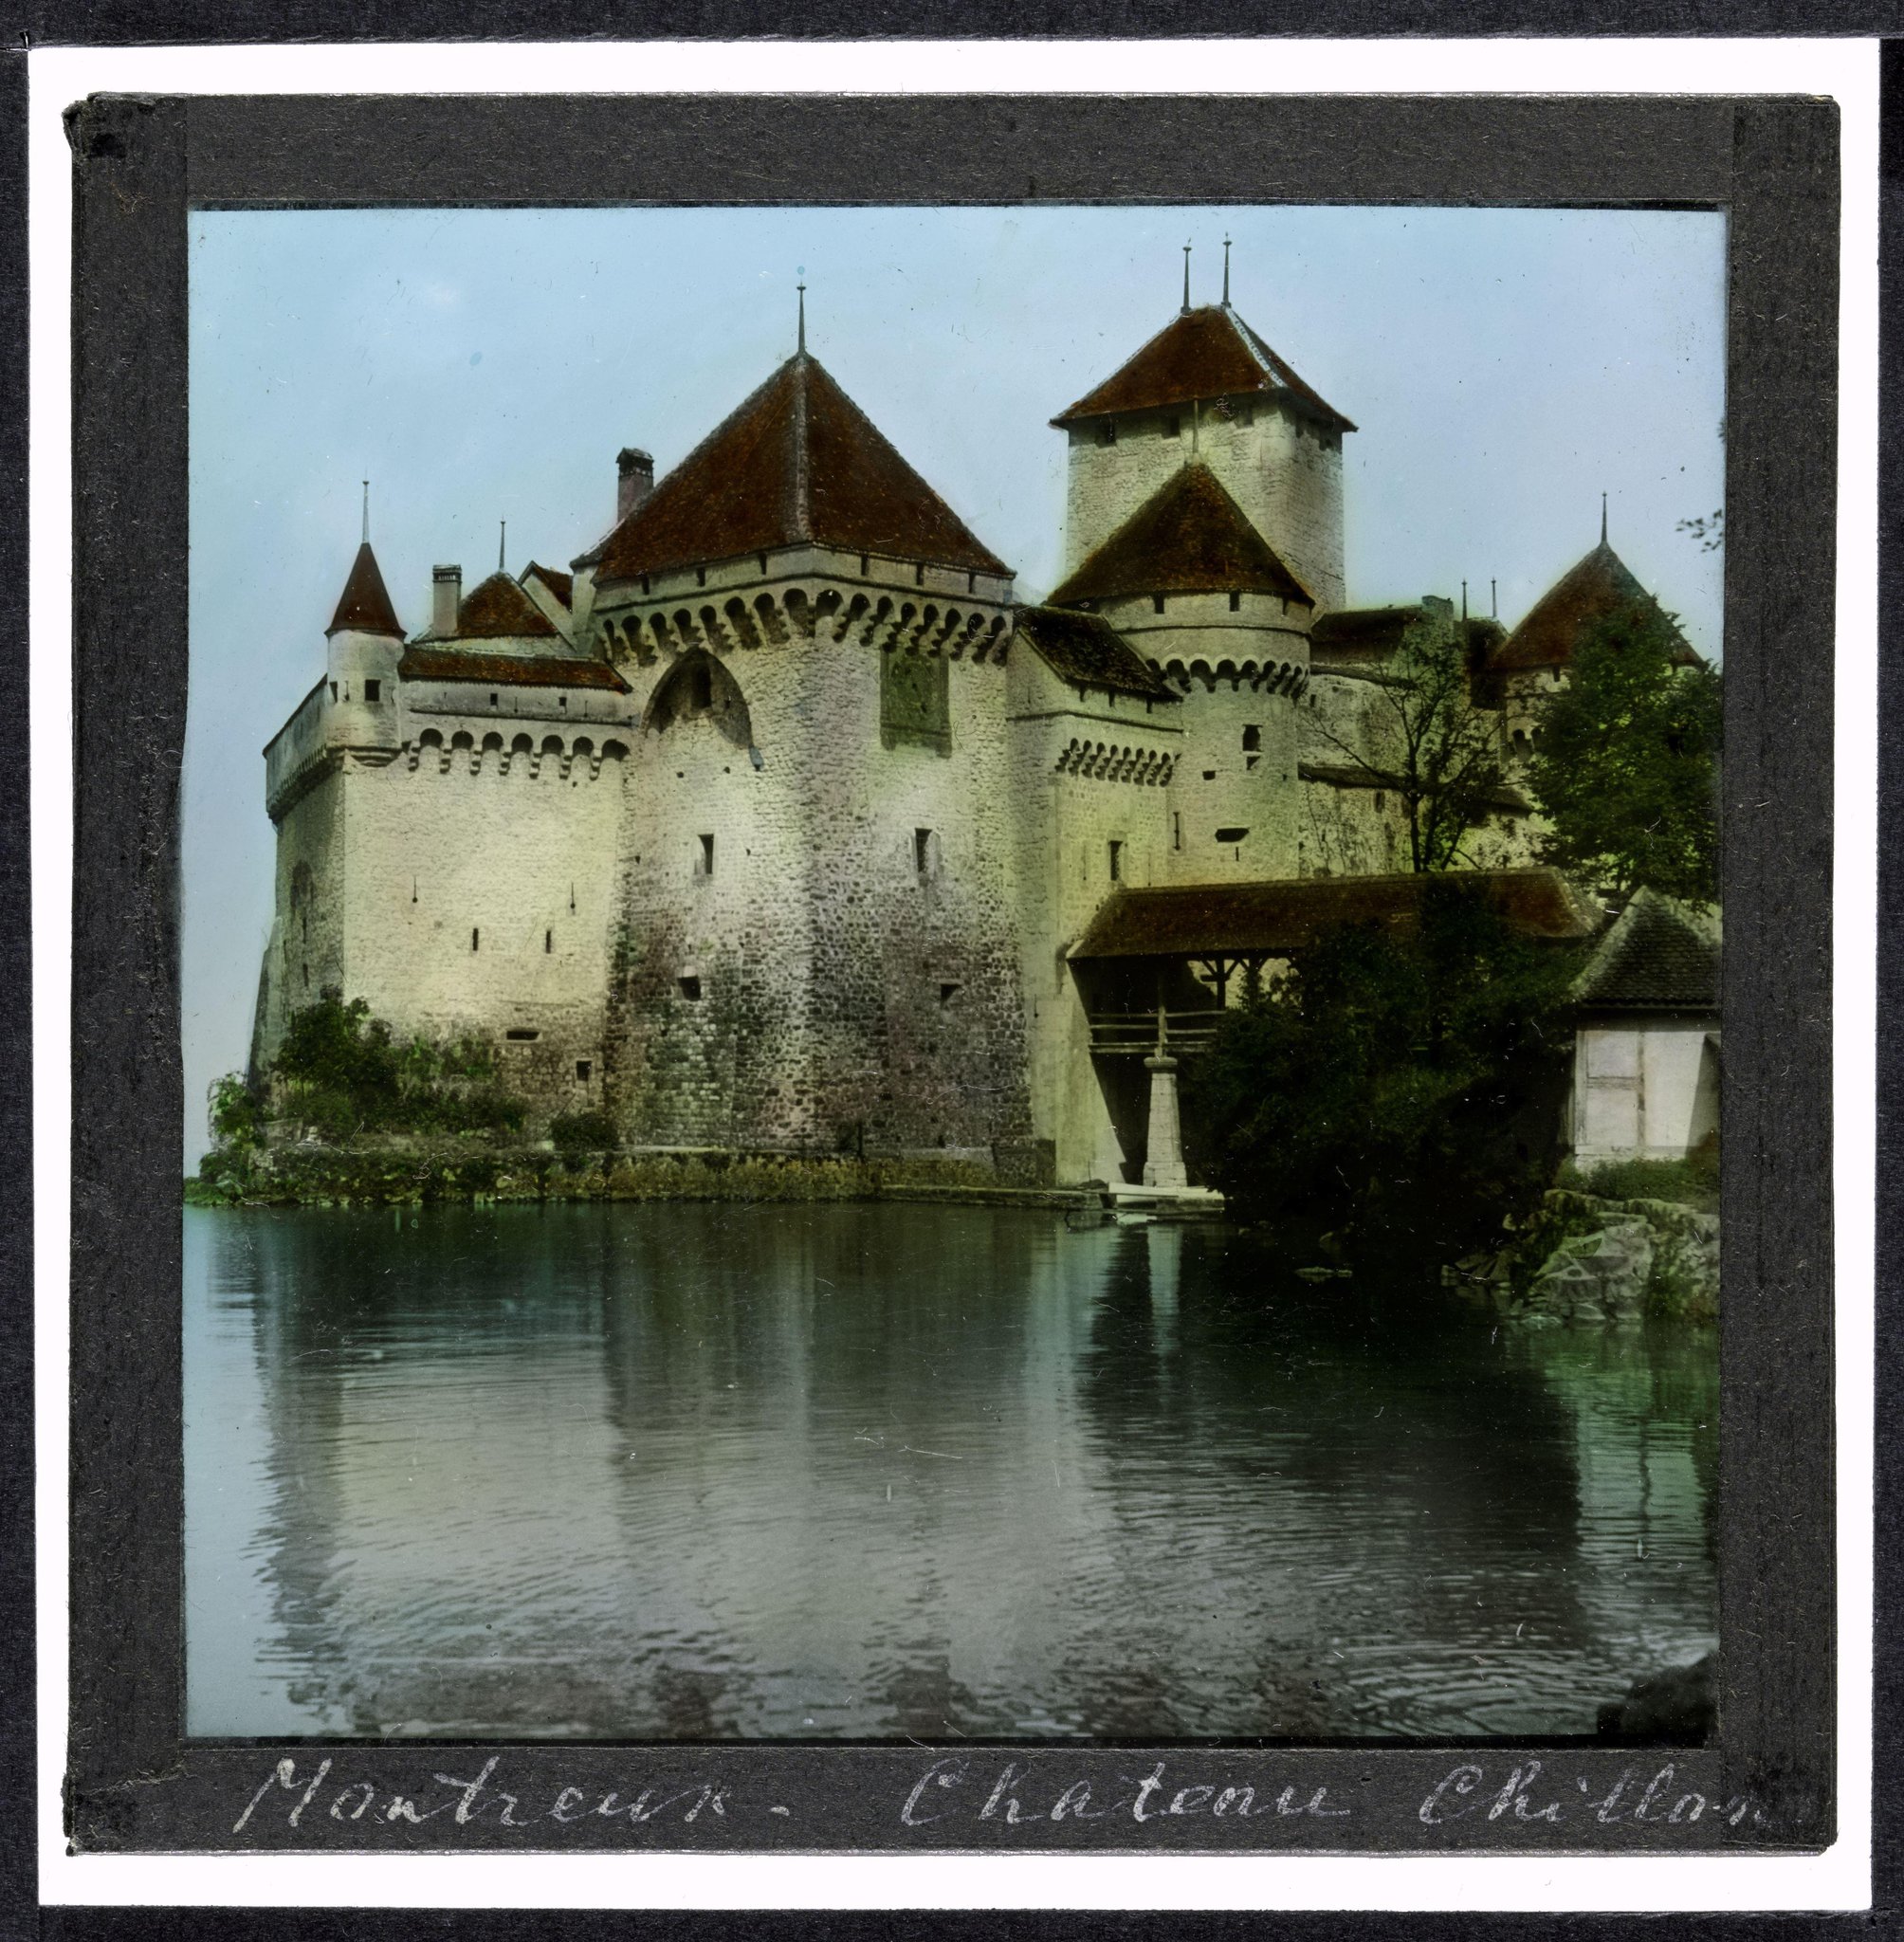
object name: glasdia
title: Gezicht op het Kasteel van Chillon aan het meer van Genève bij Montreux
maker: Anonymous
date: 1907-1935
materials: glass, ink, paper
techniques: gelatin silver transparency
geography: lake geneva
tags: castle, lake